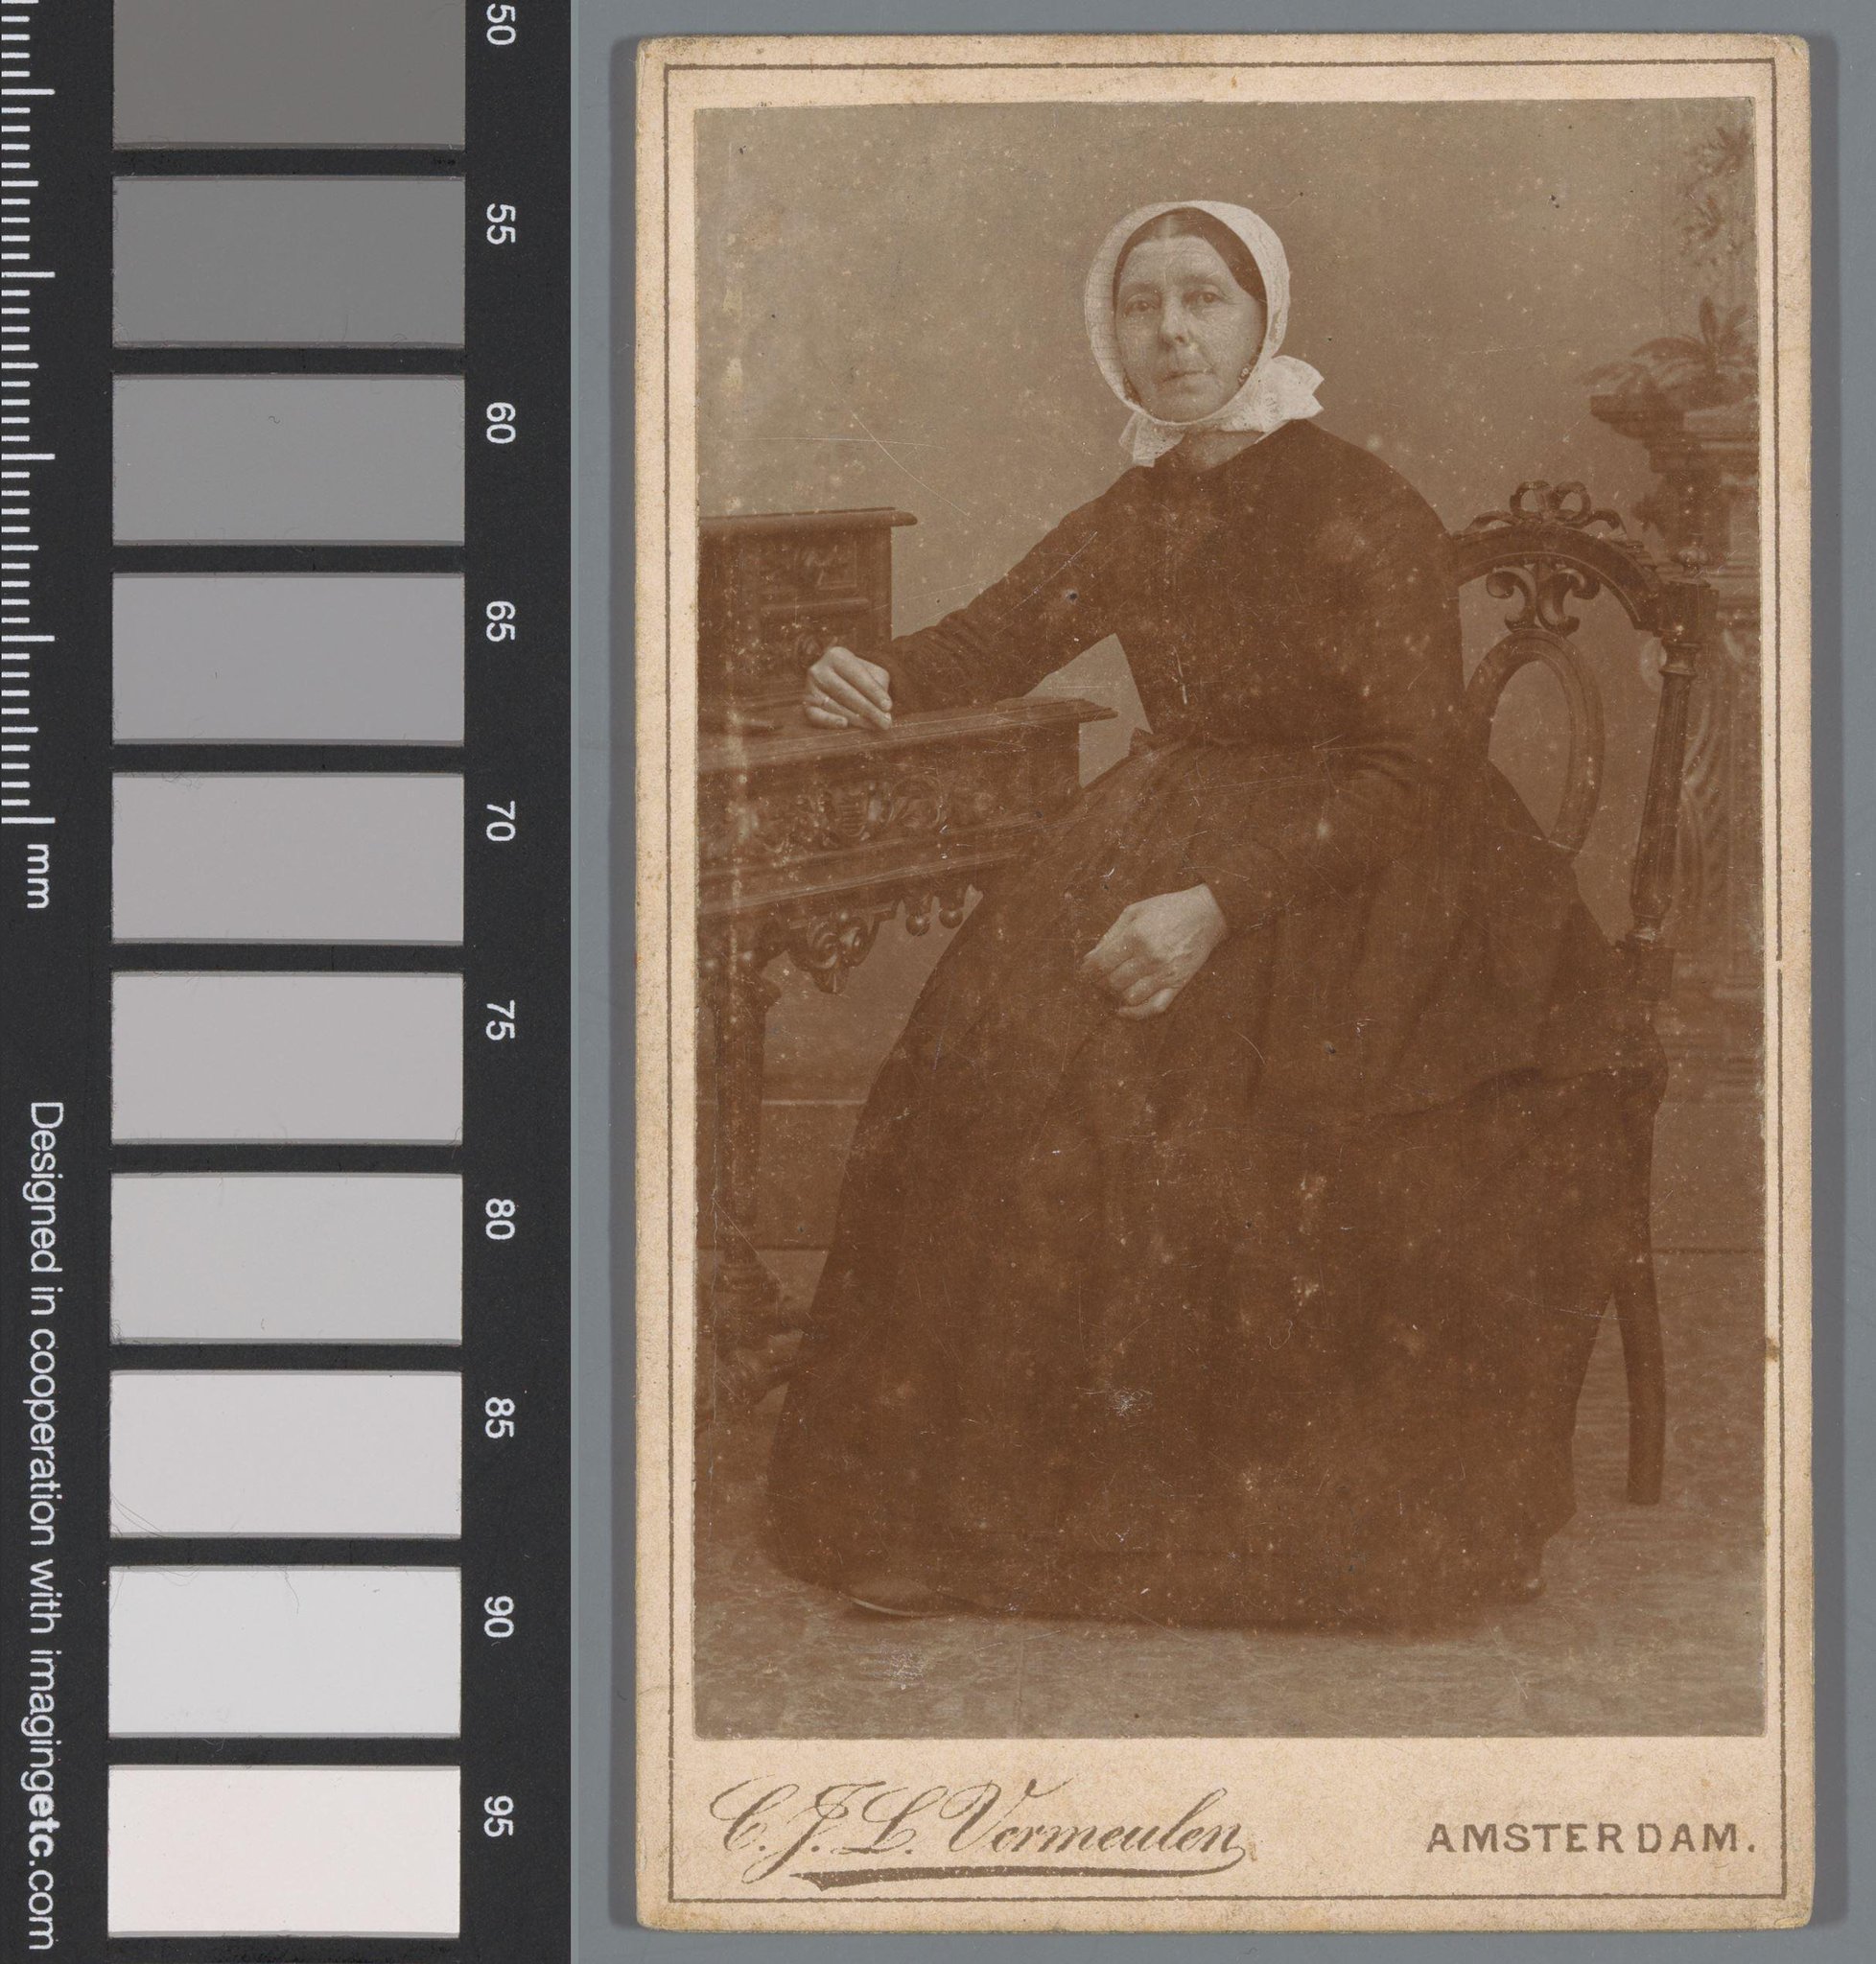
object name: carte de visite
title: Portret van een onbekende vrouw aan een bureau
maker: cornelis johannes lodewicus vermeulen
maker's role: fotograaf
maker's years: 1861-1936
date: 1888-1896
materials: paper, cardboard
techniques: collodion silver print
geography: amsterdam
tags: adult woman, anonymous historical person portrayed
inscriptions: address: ‘Heerenstraat 6,/ Heiligenweg/ hoek Singel/ Amsterdam’, inscription: ‘Specialiteit in vergrootingen.’